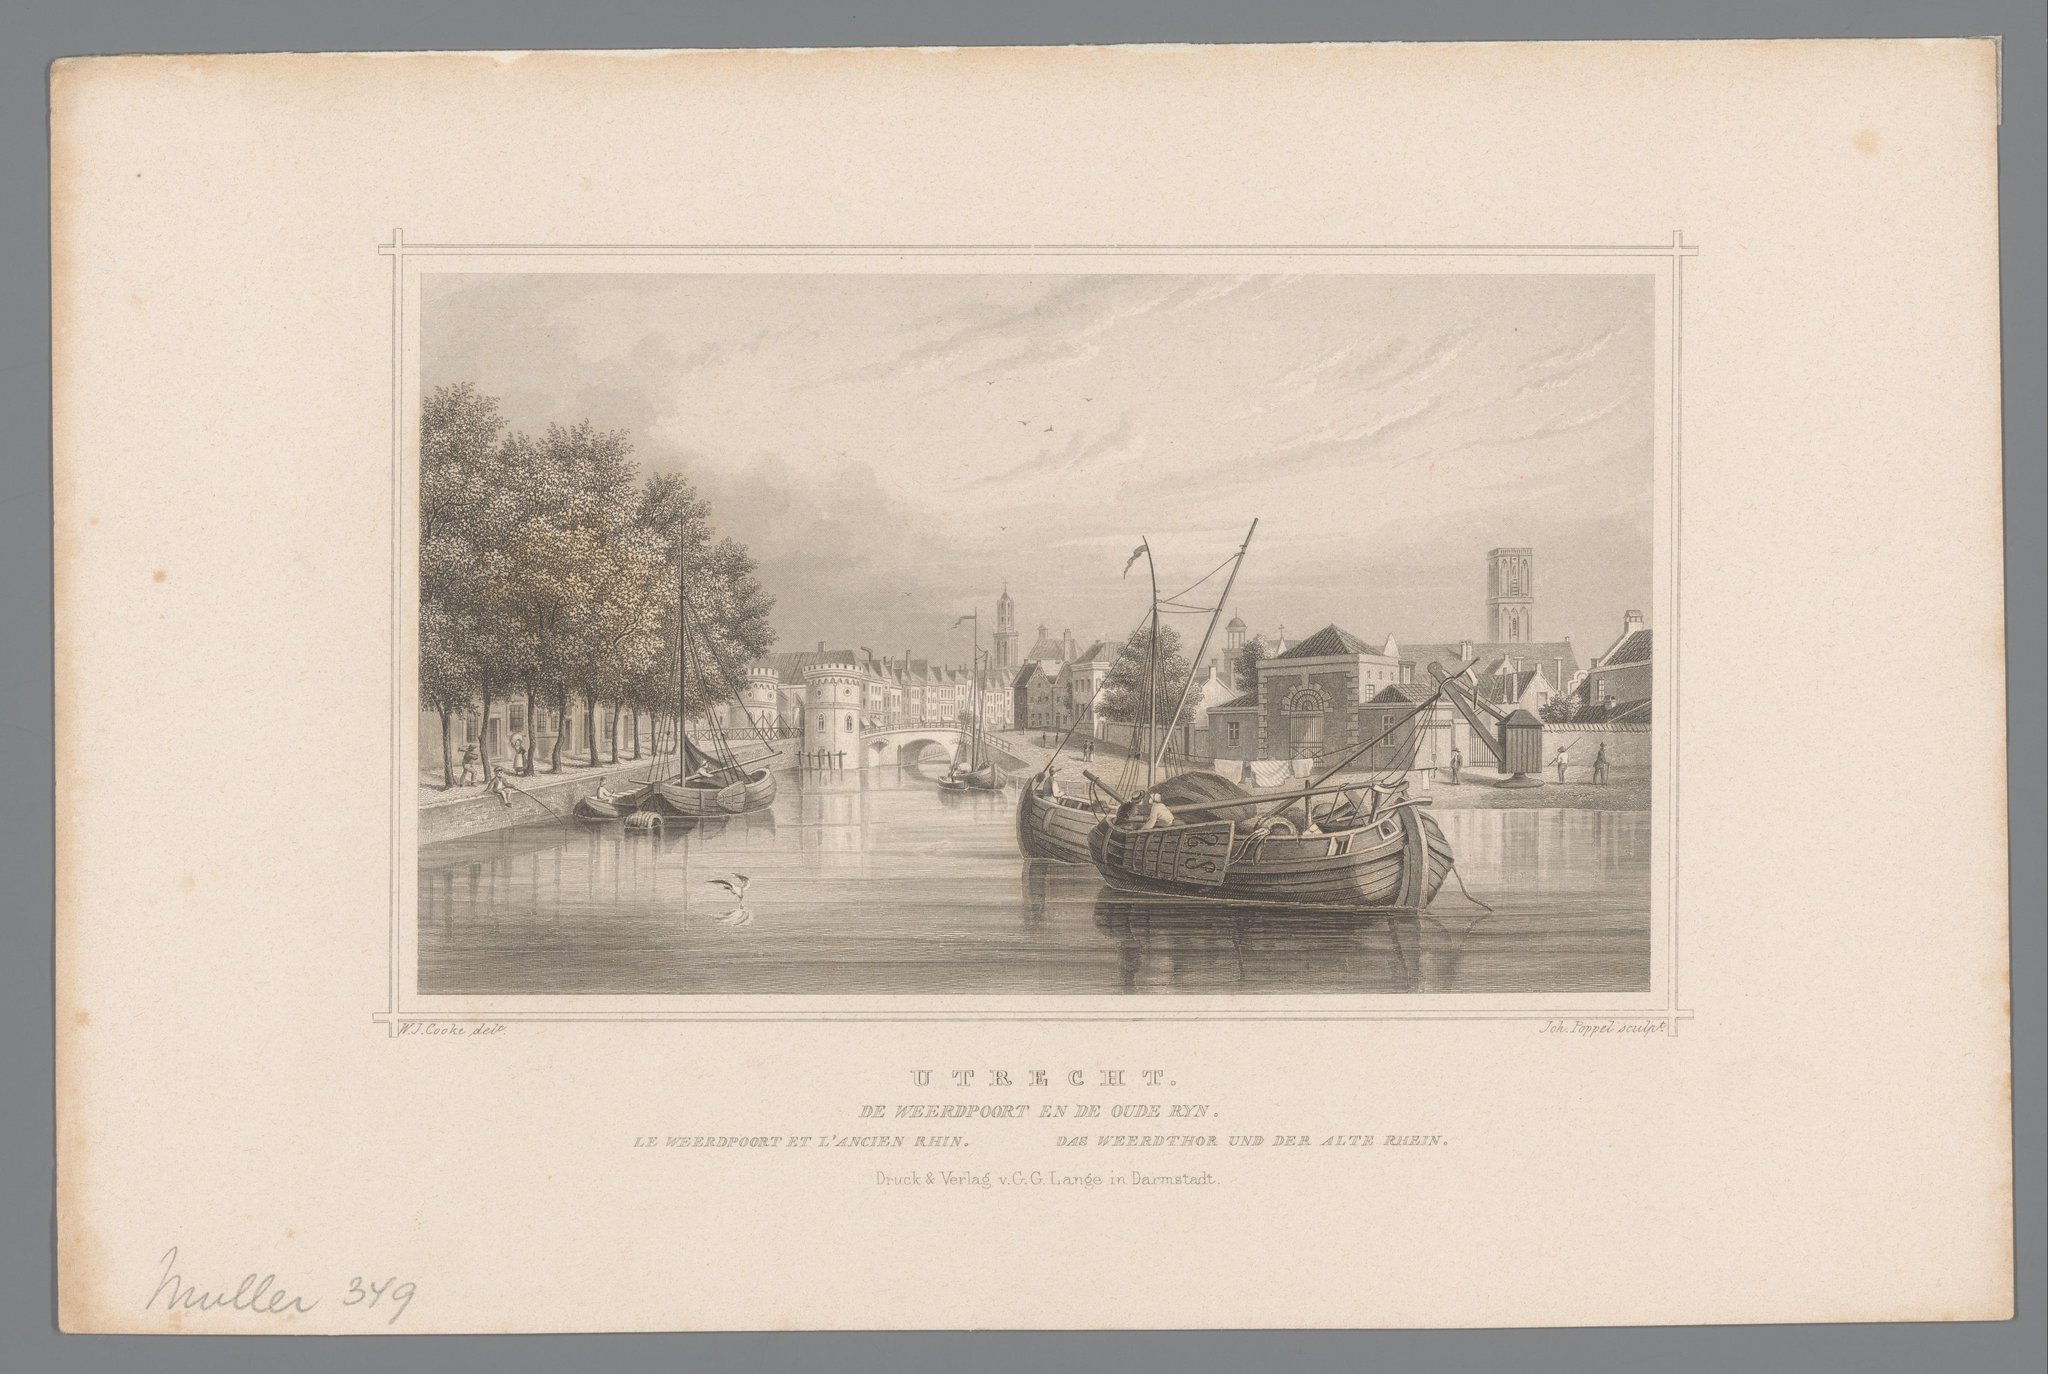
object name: print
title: Gezicht op de Weerdpoort en de Oude Rijn te Utrecht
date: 1863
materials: paper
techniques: engraving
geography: darmstadt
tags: city-view, and landscape with man-made constructions, canals, waters (in city), utrecht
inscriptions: collector's mark: Lugt 2233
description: Prent uit: Terwen, J.L. Het koningrijk der Nederlanden voorgesteld in eene reeks van 136 naar de natuur geteekende schilderachtige gezigten. Darmstadt: G.G. Lange, 1863.